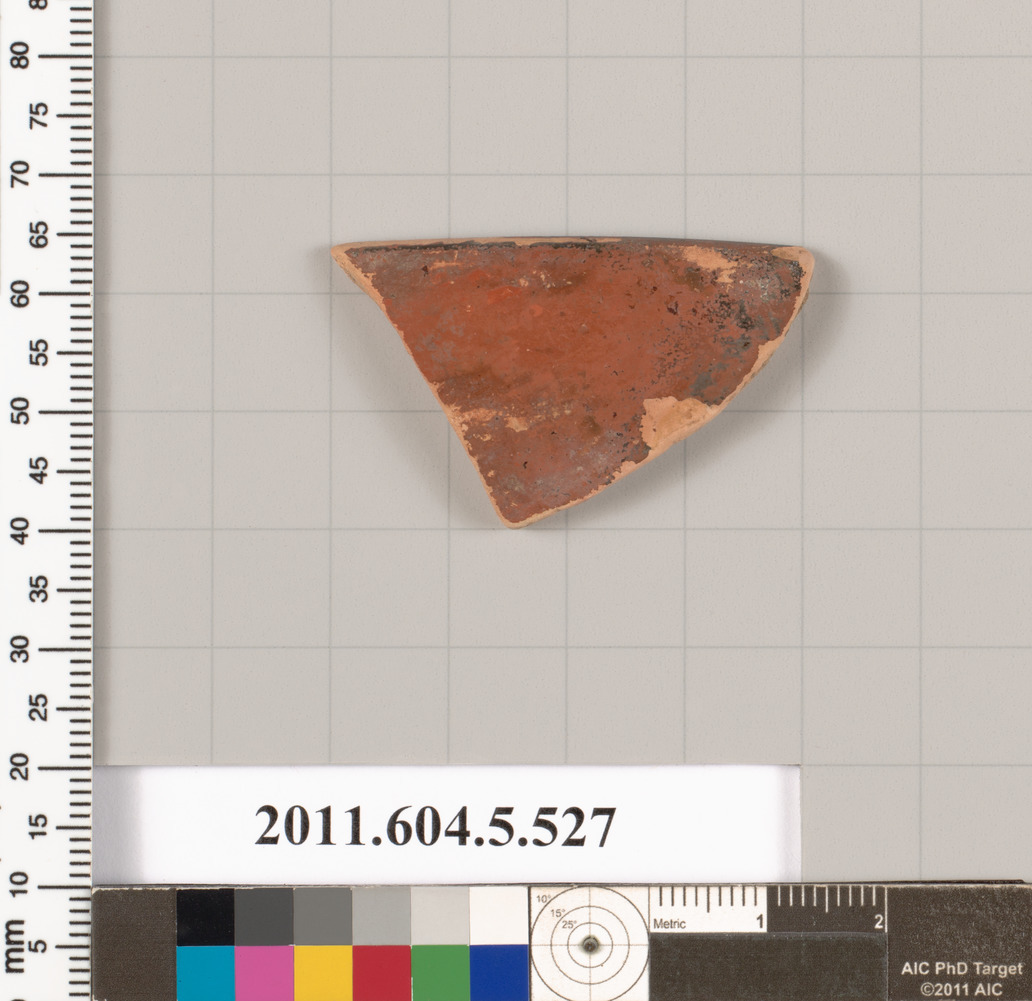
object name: kylix fragment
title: Terracotta rim fragment of a kylix (drinking cup)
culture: greek, attic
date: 600-401 BCE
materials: terracotta